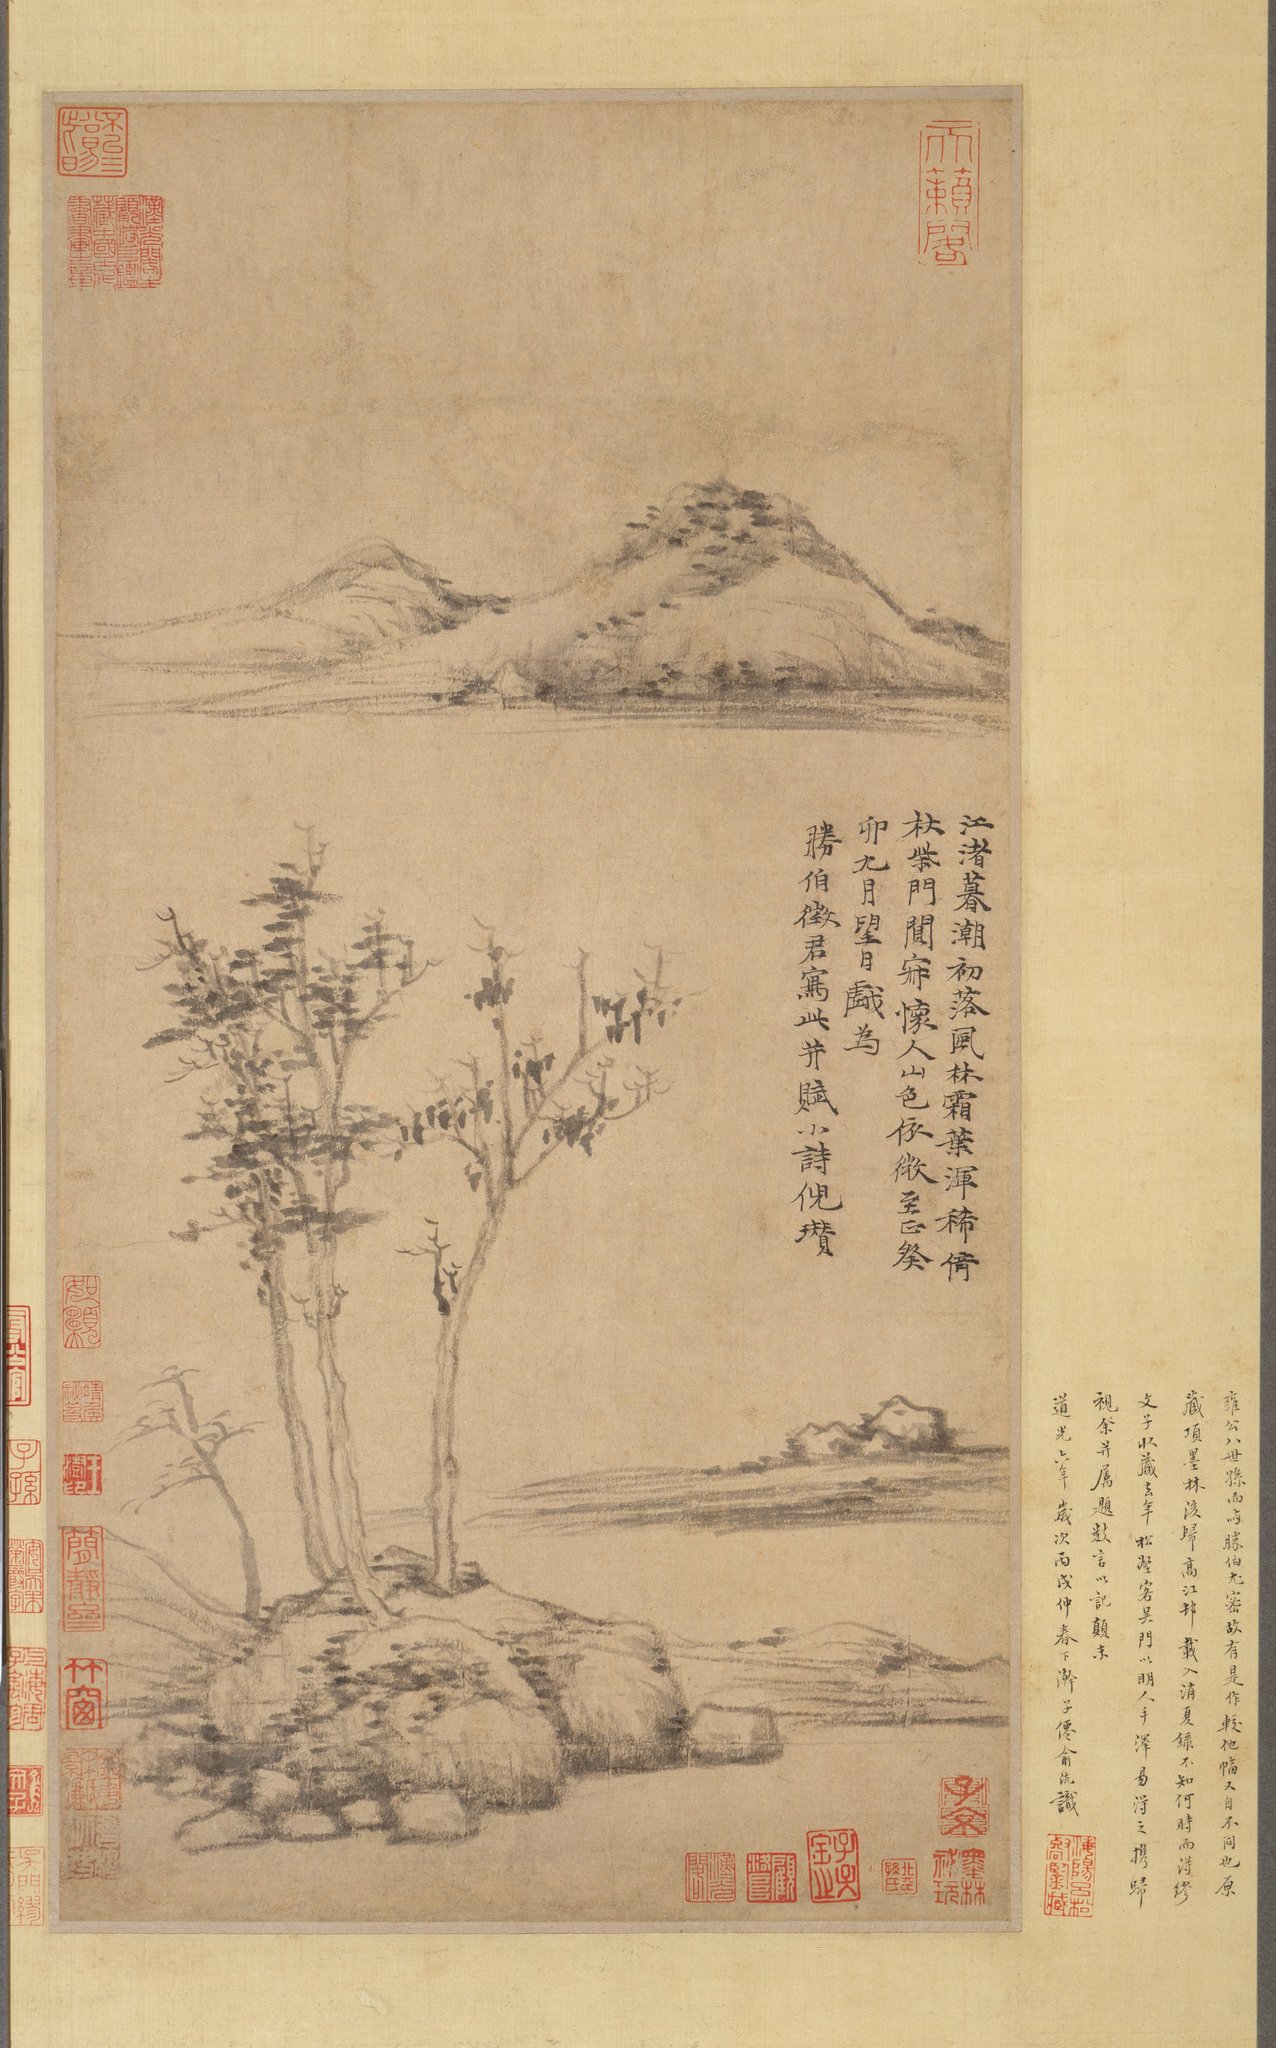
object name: hanging scroll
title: Wind among the Trees on the Riverbank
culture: chinese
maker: ni zan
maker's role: artist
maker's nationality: chinese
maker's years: 1306-1374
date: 1363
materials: ink, paper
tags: mountains,landscapes,trees